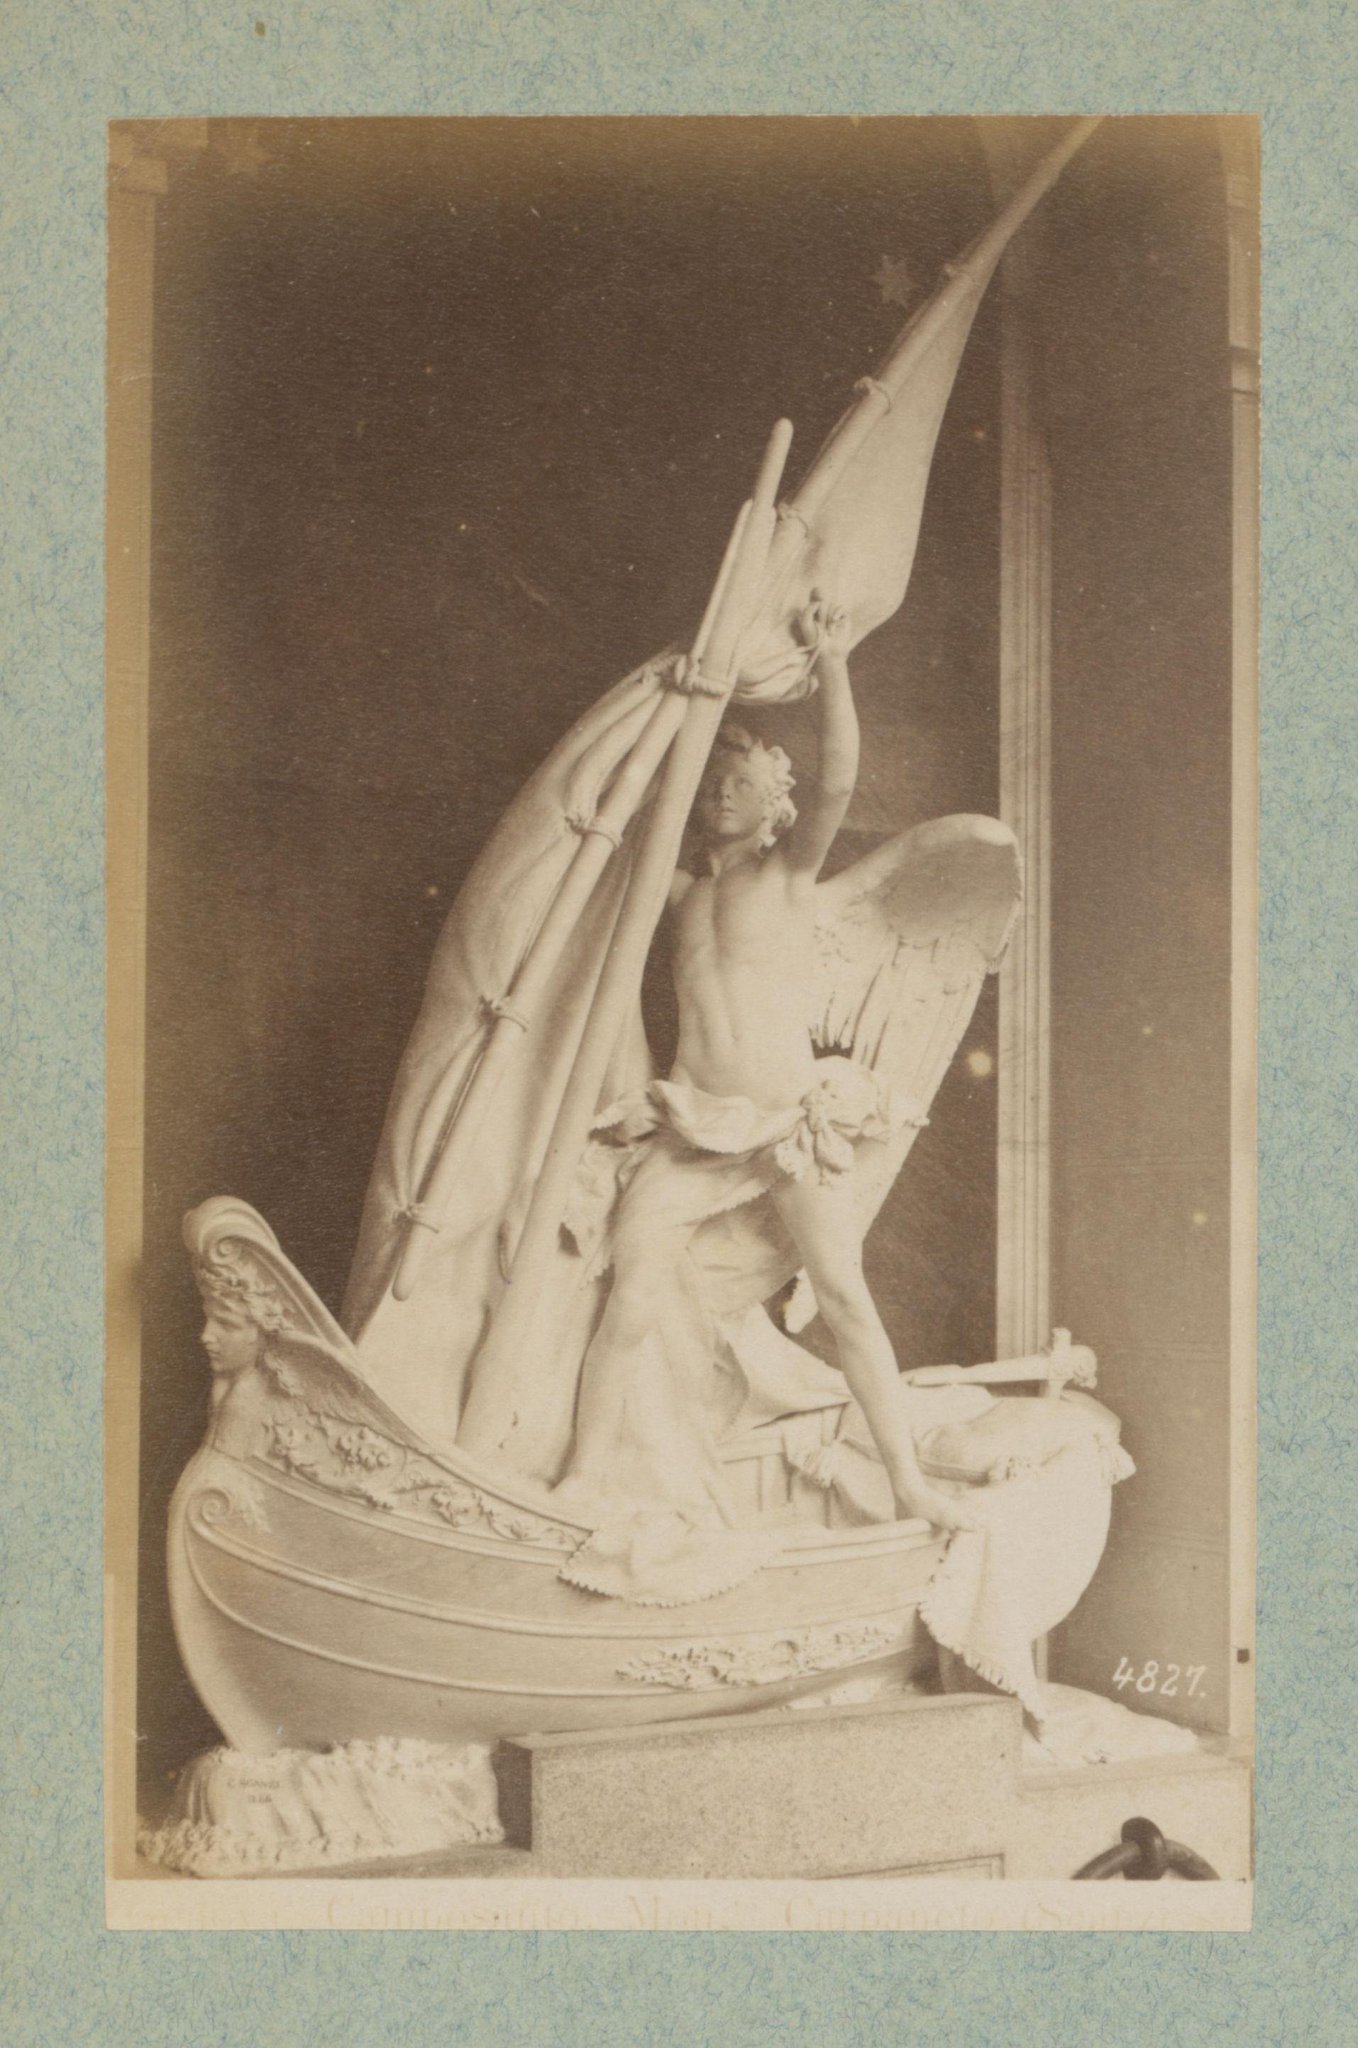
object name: photograph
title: Camposanto. Mon. Carpaneto (Scanzi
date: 1886-1890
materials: cardboard, paper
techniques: albumen print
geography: genoa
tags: sculpture, grave-building, monumental tomb, angels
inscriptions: number: ‘4827.’, collector's mark: ‘VOSMAER’